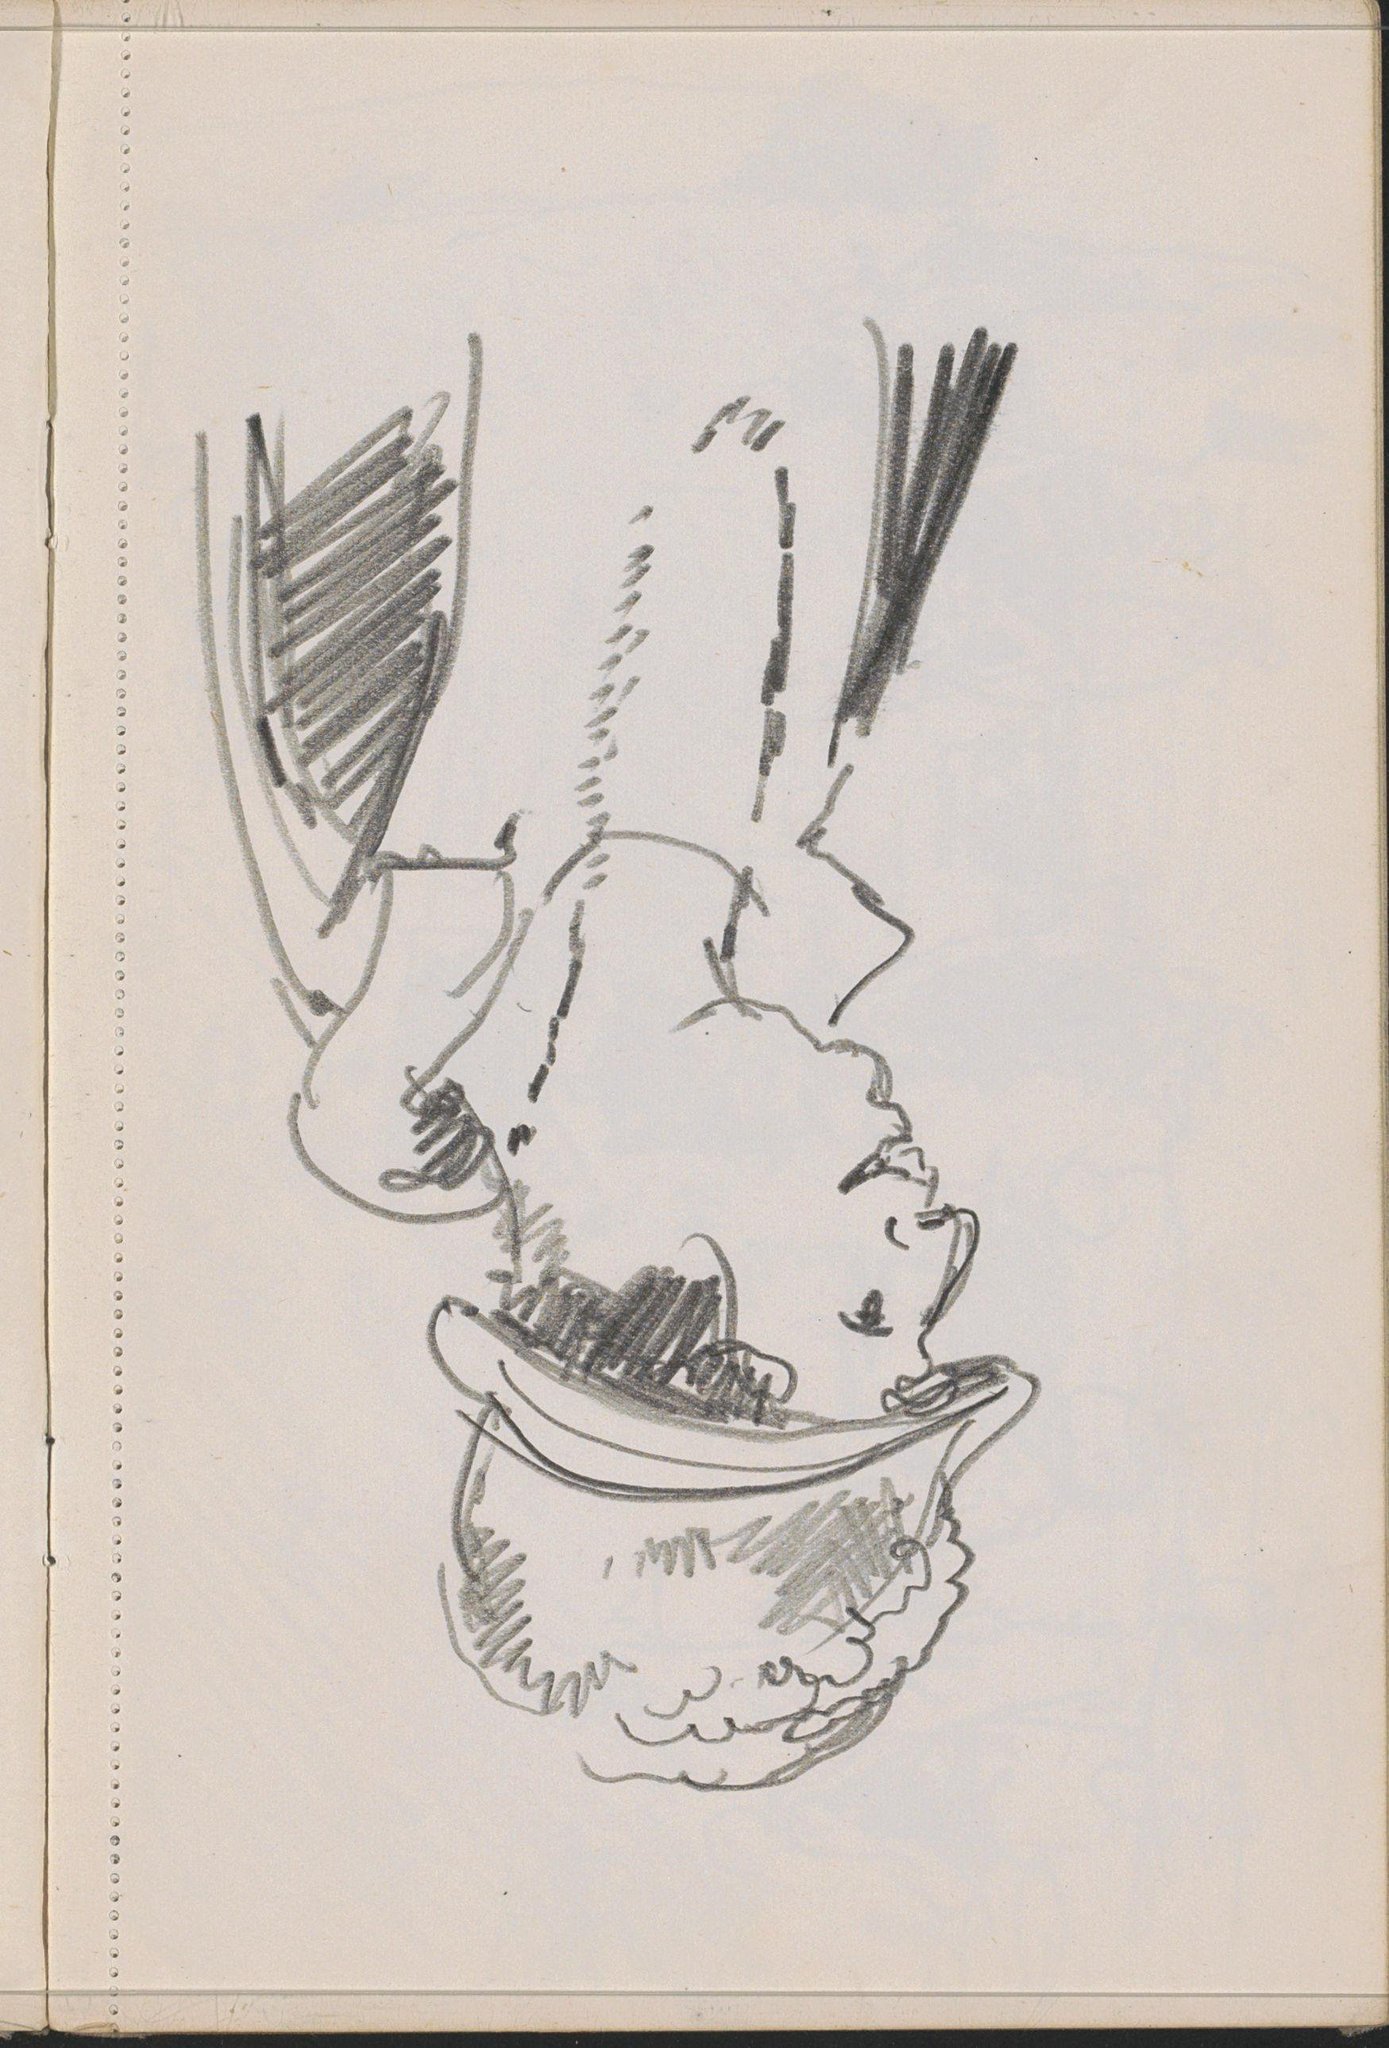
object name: sketchbook leaf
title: Portret van een vrouw met een blouse met opstaande kraag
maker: cornelis vreedenburgh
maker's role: draughtsman, print maker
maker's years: 1880-1946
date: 1890-1946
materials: paper, pencil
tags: adult woman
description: De vrouw draagt tevens een hoed en een lange halsketting. Blad 13 recto uit een schetsboek met 53 bladen.